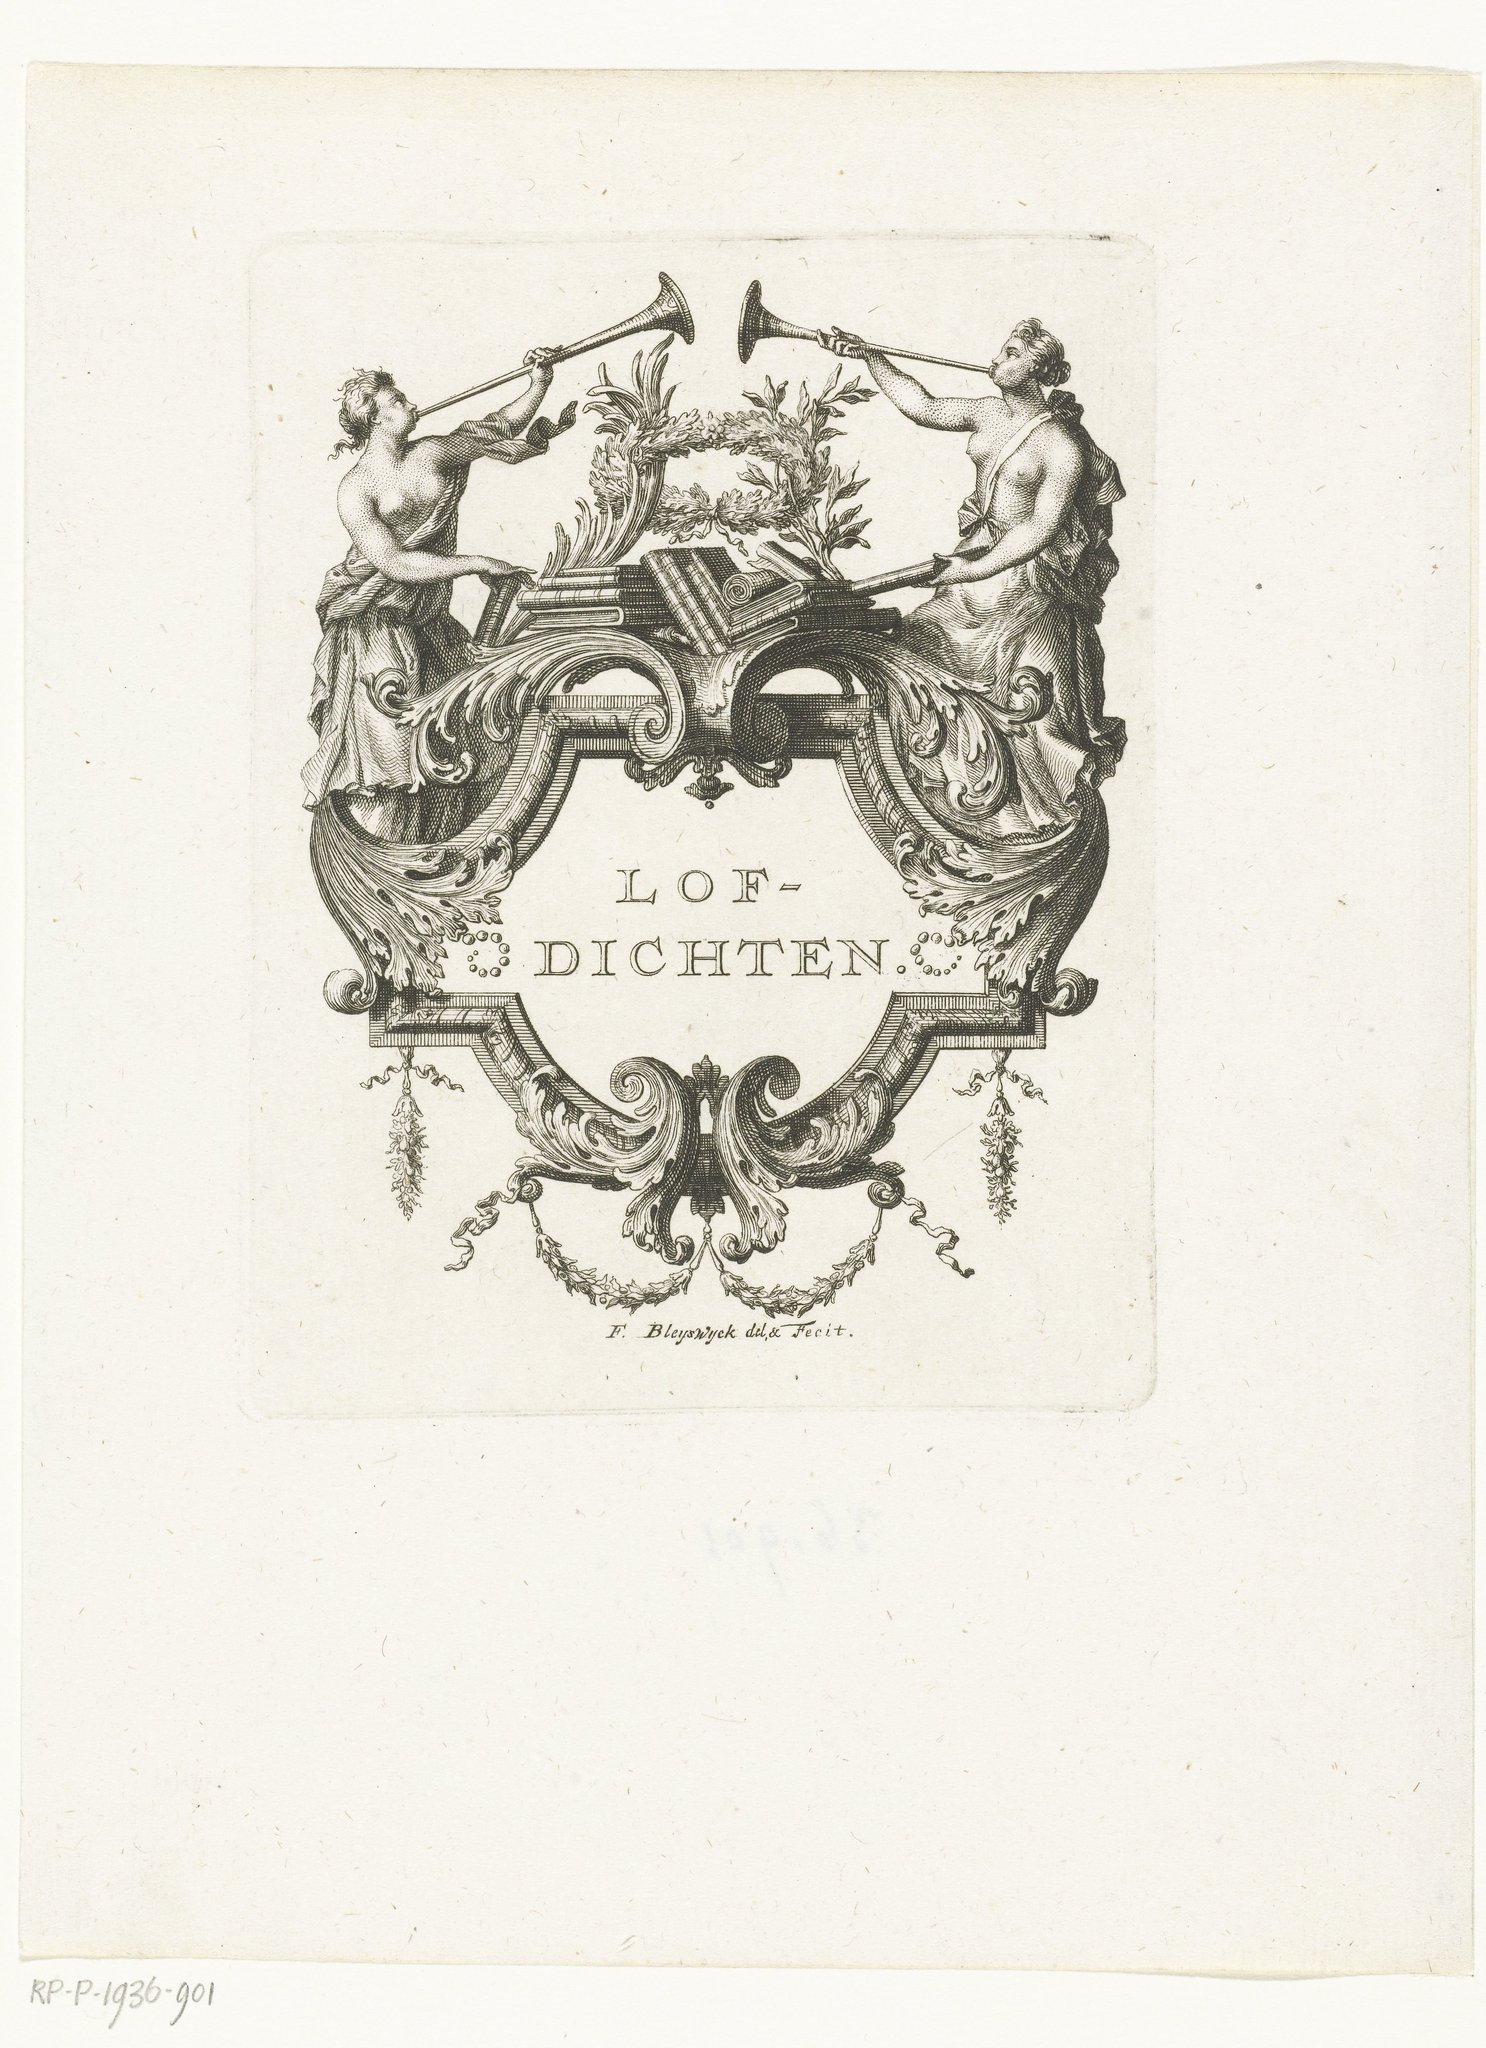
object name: print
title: Lofdichten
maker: françois van bleyswijck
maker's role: draughtsman, print maker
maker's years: 1671-1746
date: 1681-1720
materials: paper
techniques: engraving, etching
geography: leiden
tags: fame; 'fama', 'fama buona', 'fama chiara' (ripa)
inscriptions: collector's mark: Lugt 2760, collector's mark: Lugt 2228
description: Titelvignet met omlijsting waarin twee vrouwen zijn opgenomen, als personificaties van Roem blazen zij op trompetten. Zij flankeren stapels boeken die worden bekroond met een krans van eikenbladeren.